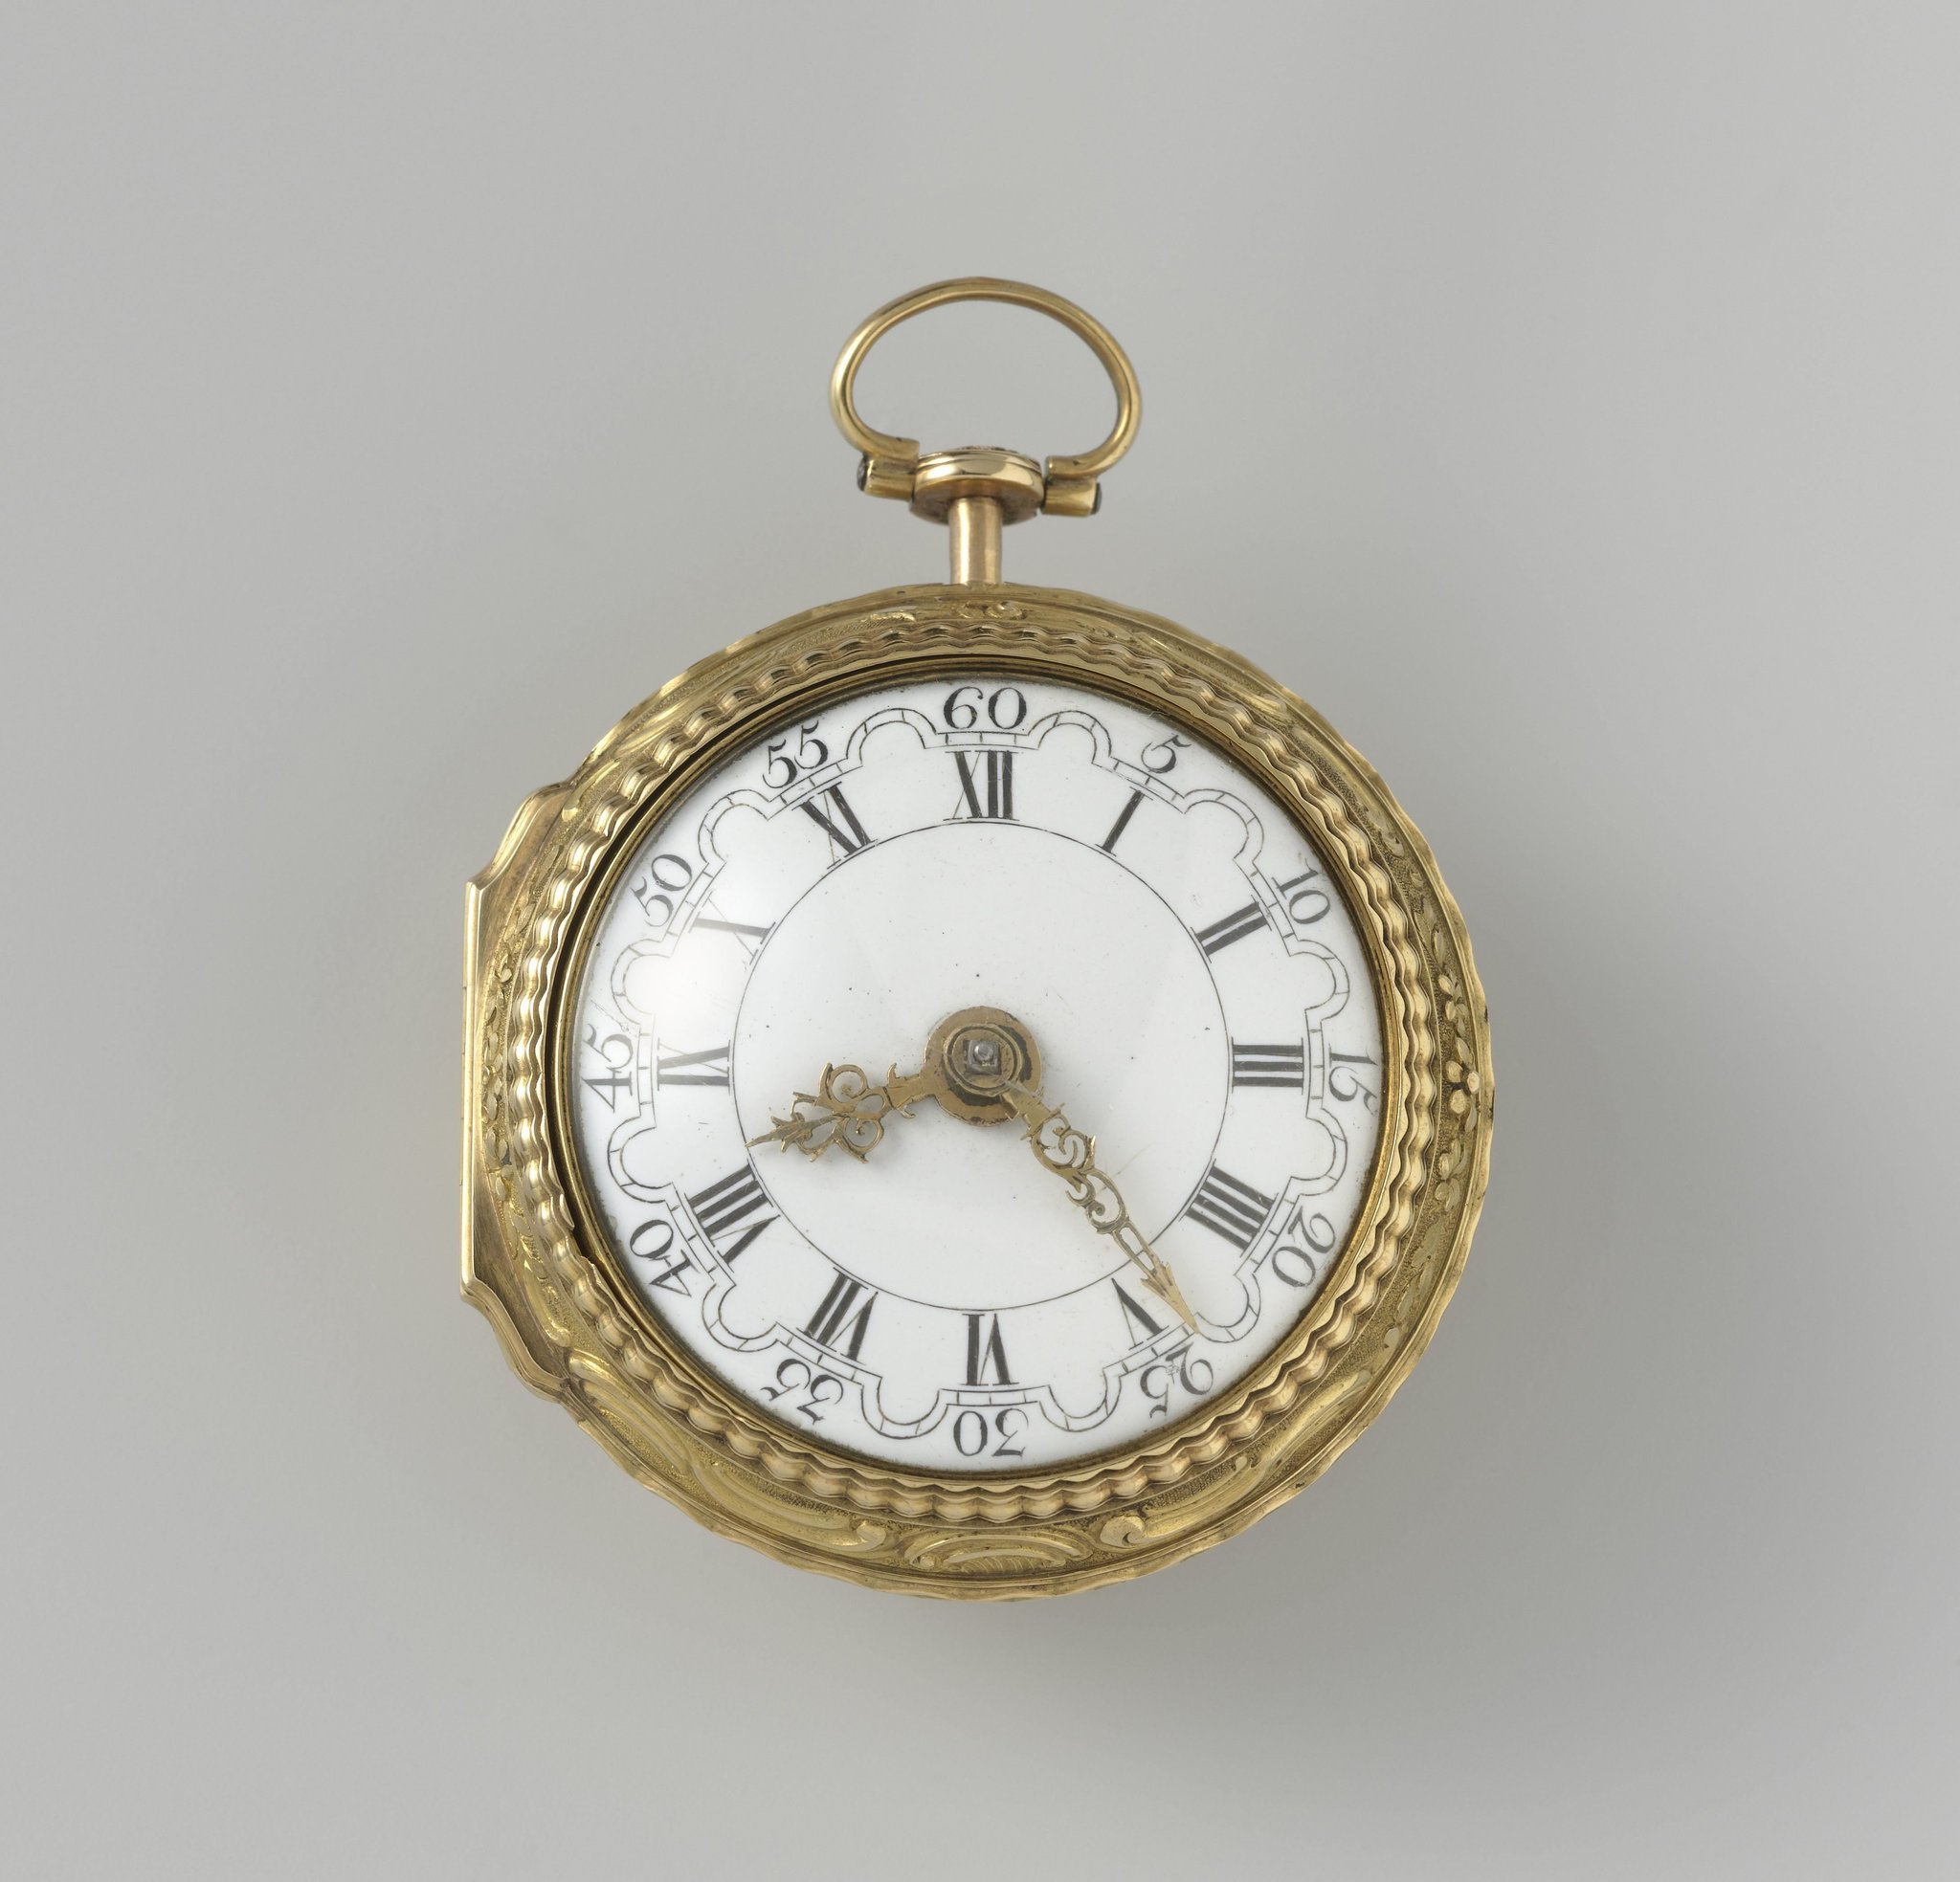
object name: jewellery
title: Watch with the Liberation of Andromeda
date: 1765-1766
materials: gold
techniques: repoussé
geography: rotterdam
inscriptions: date letter: ‘H of K’, mark: ‘saterkop’, maker's mark: ‘I W’, mark: ‘liggende leeuw’, signature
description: Zakhorloge, etui van schildpad, gouden binnenkast, zeldzaam mooi gedreven in hoog-reliëf, voorstellend de bevrijding van Andromeda, Nederlandse émail wijzerplaat met gouden wijzers, fraaie zilveren kloof met putto, inscriptie: kent uzelve, gemerkt: Michiel de Haan, Rotterdam, nr 15.